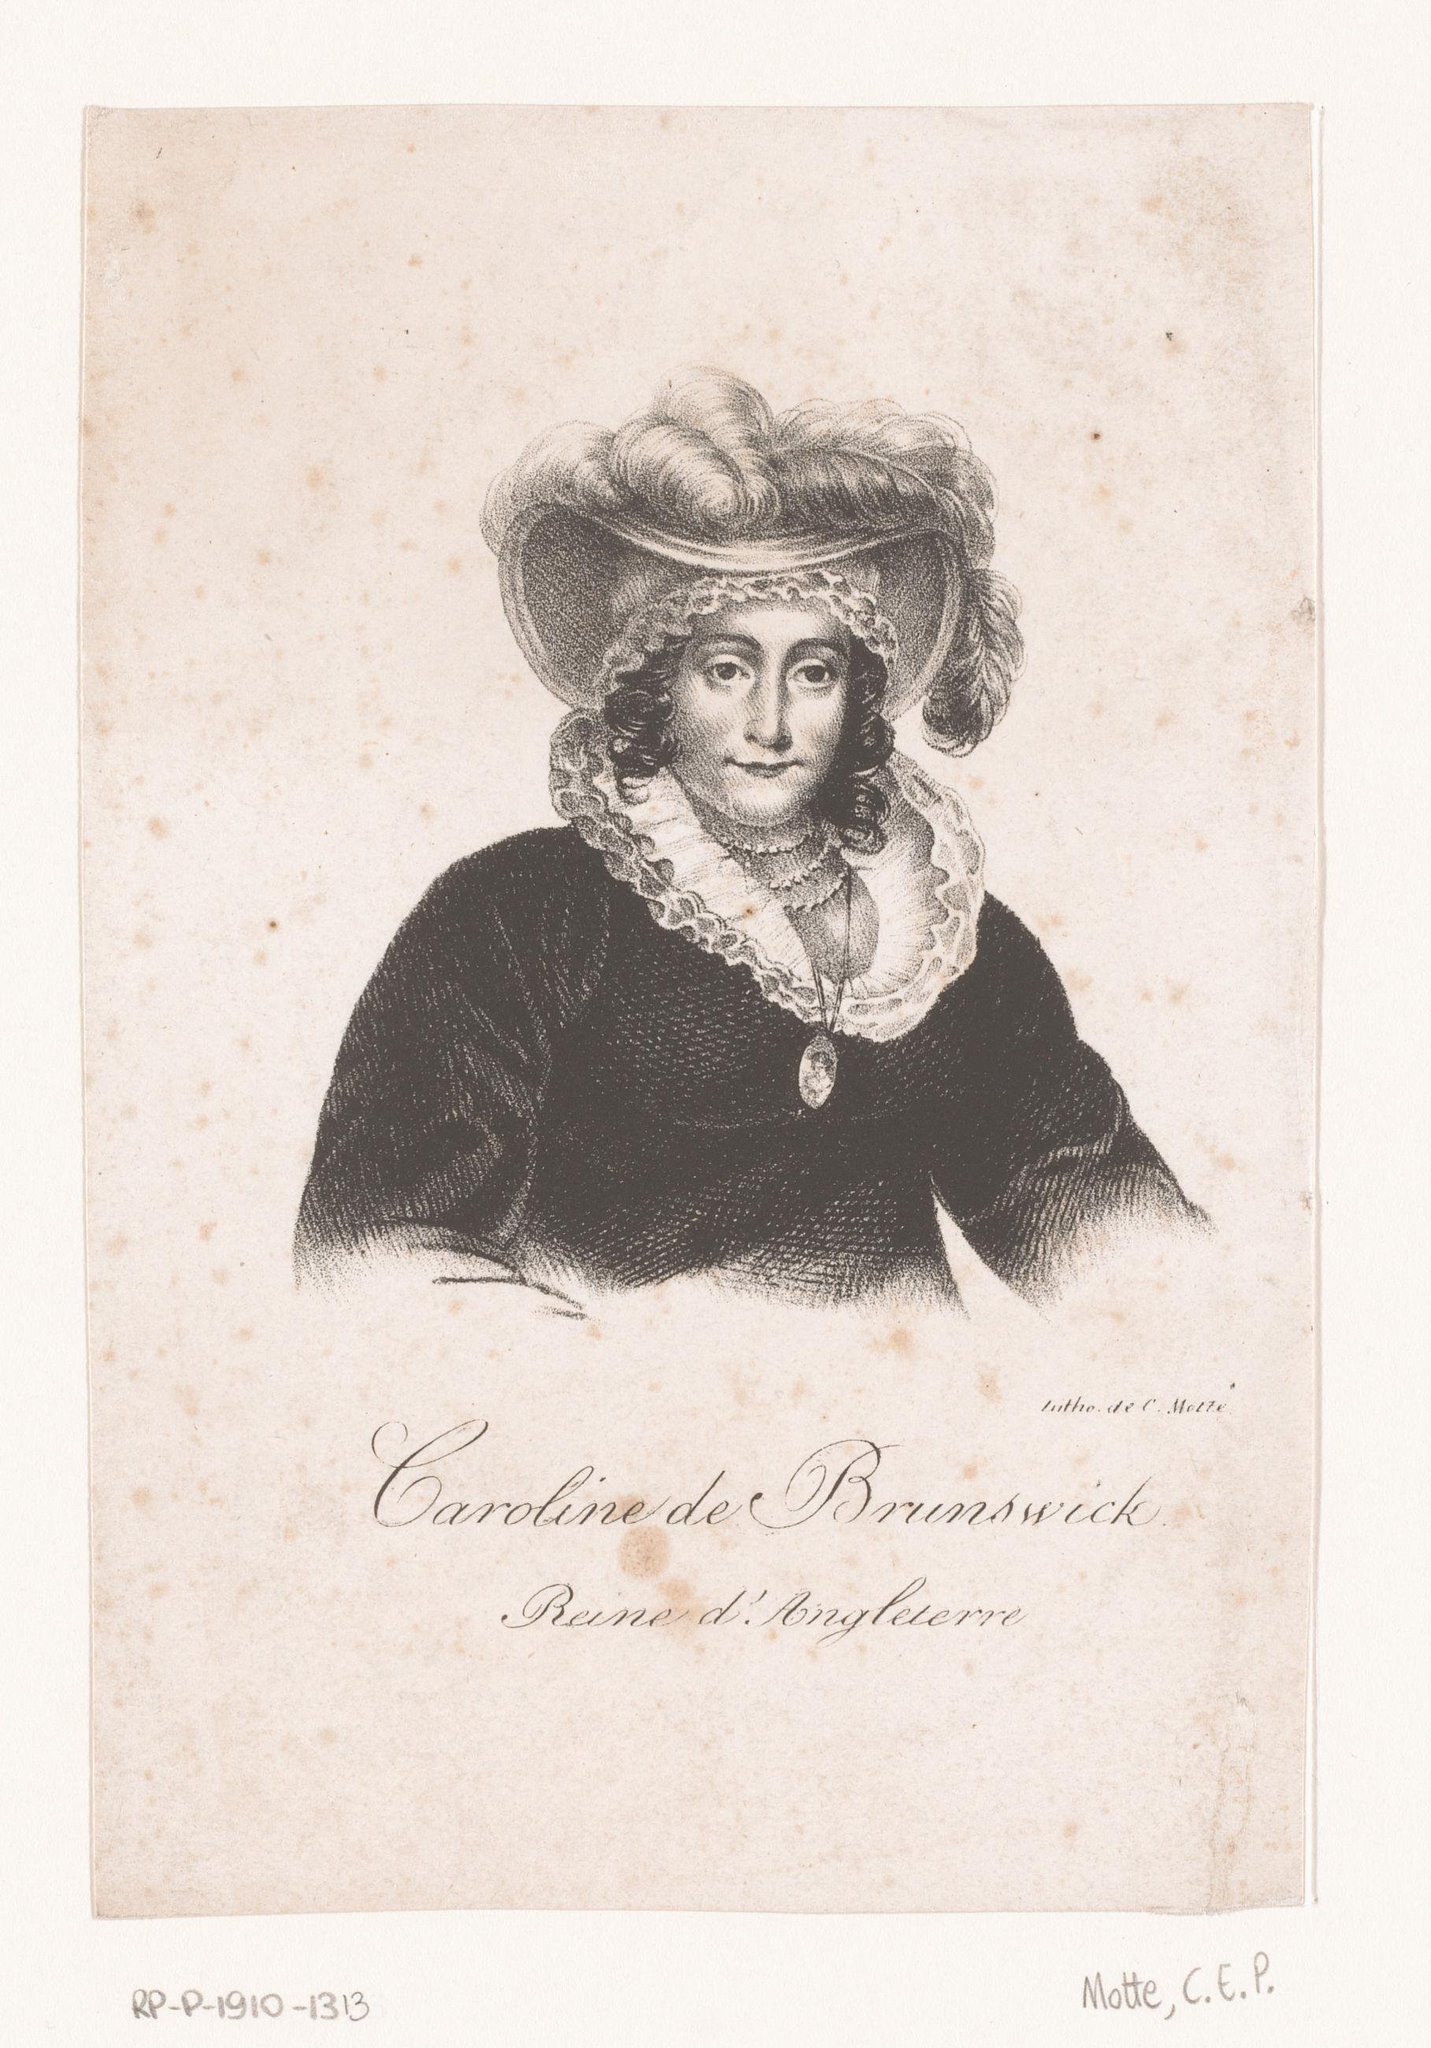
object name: print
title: Caroline de Brunswick, reine d'Angleterre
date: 1817-1837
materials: paper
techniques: lithograph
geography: paris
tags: london, historical persons, princess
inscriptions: collector's mark: Lugt 2228